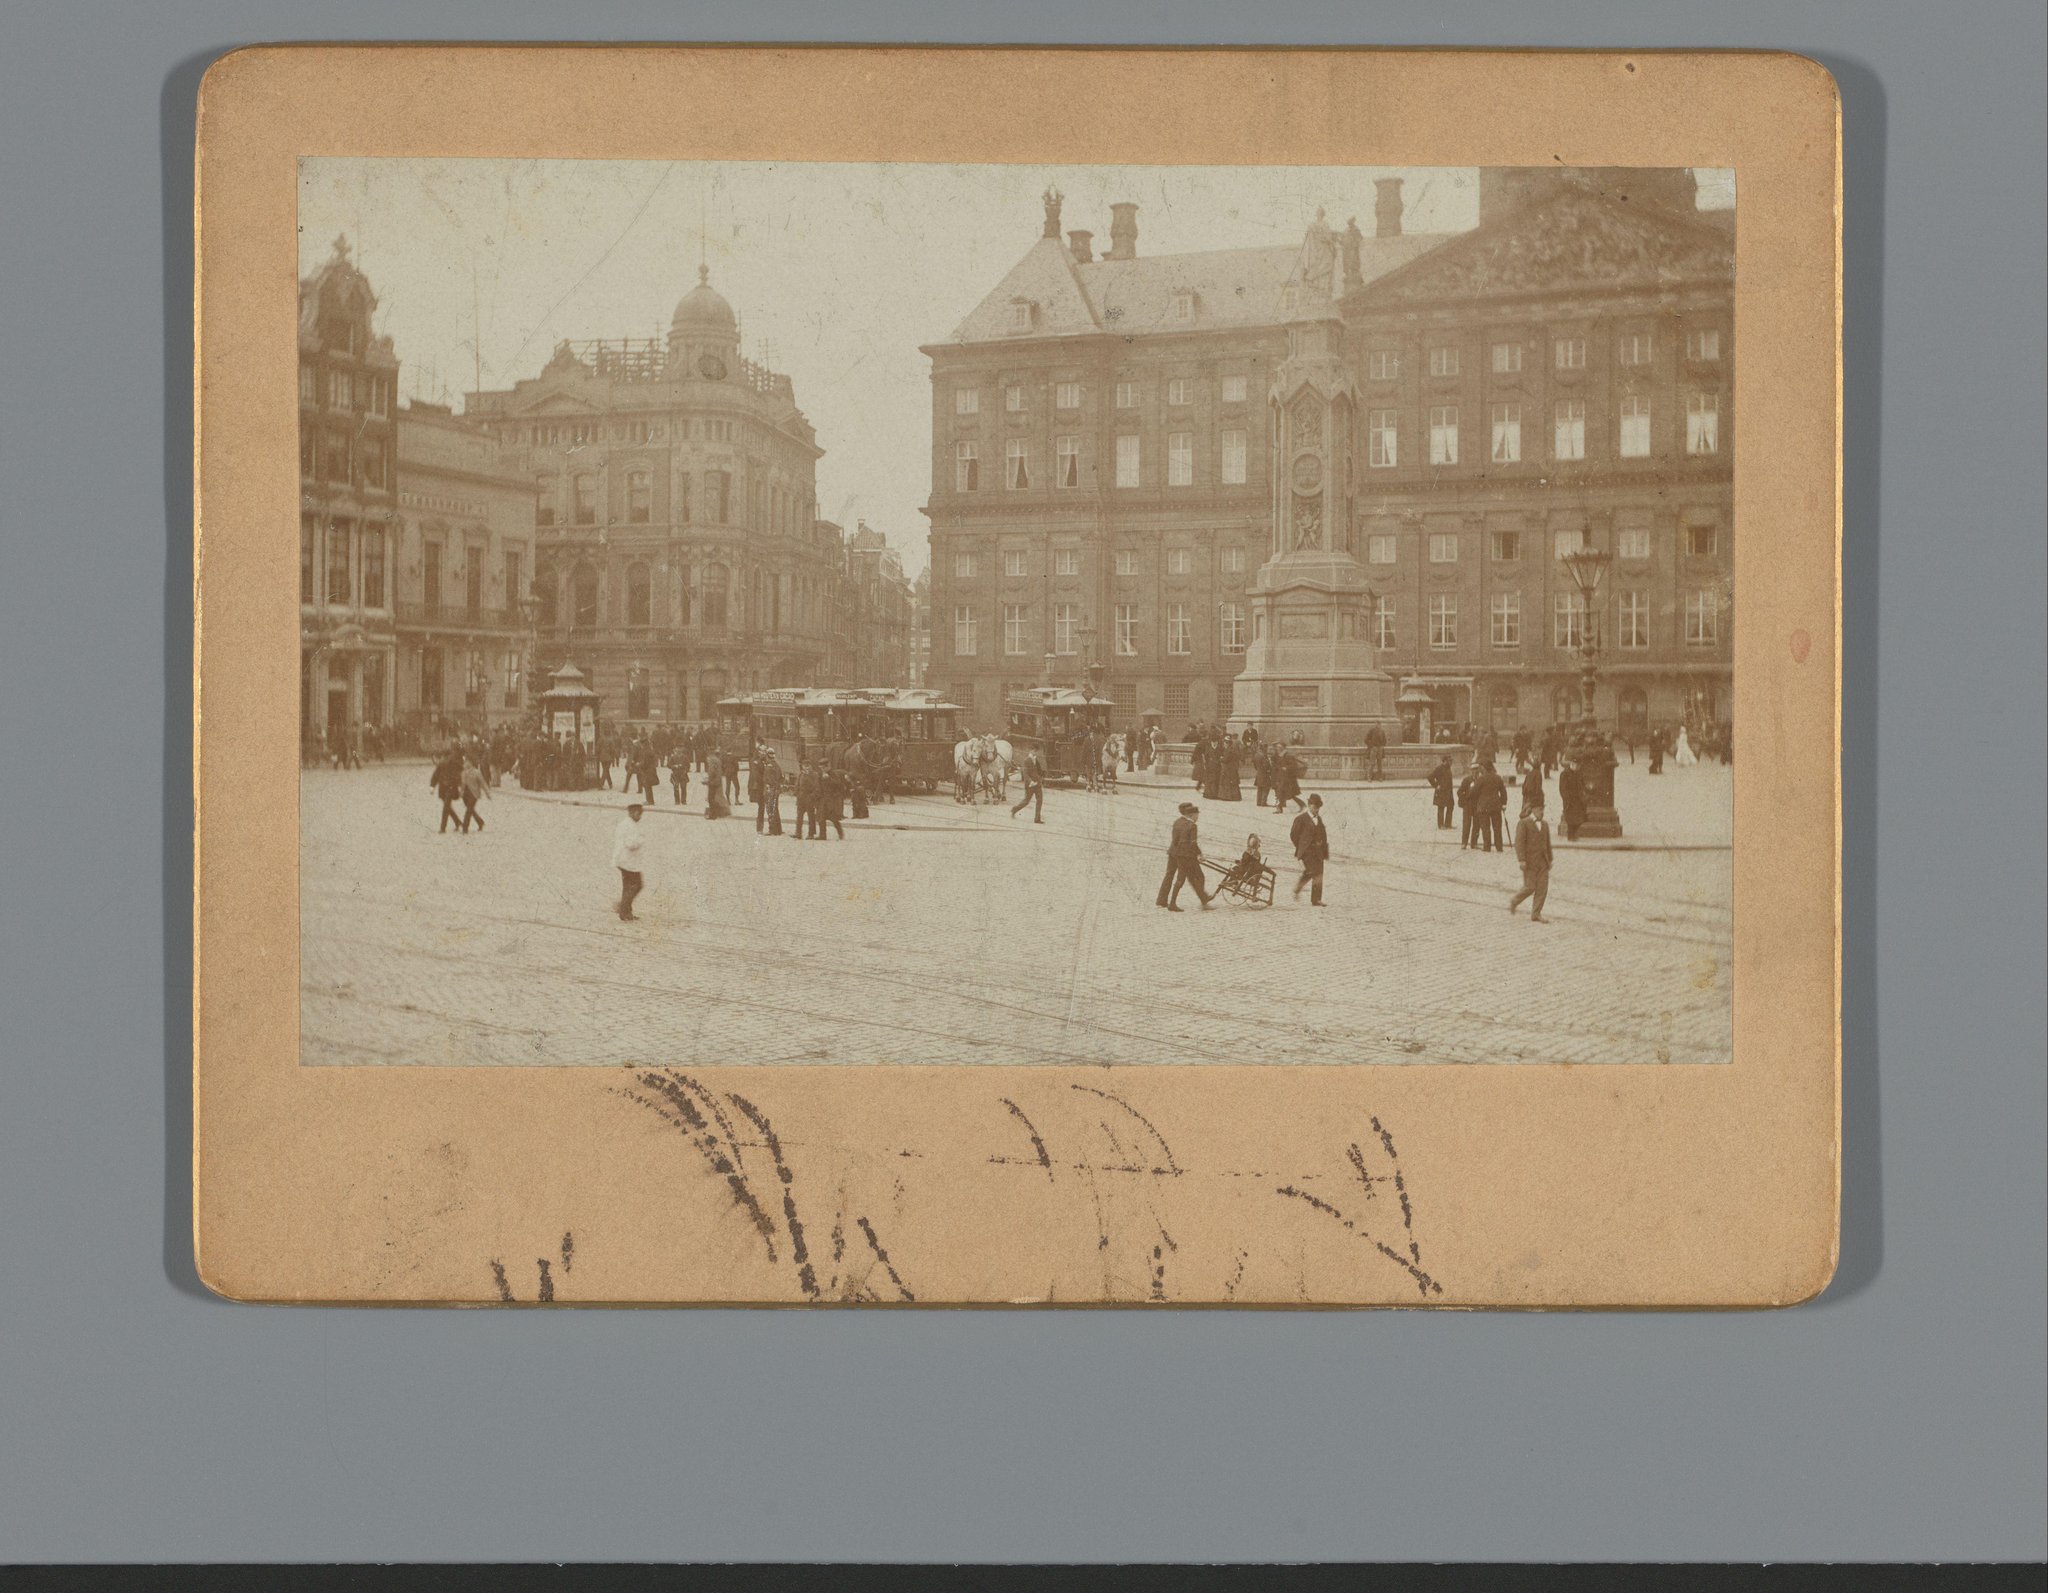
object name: photograph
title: Gezicht op de Dam met paardentrams in Amsterdam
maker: gerrit van der mey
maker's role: gynaecoloog, professor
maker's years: 1851-1895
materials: cardboard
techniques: gelatin silver print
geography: amsterdam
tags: dam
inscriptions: inscription: ‘Mies Schürer Ruth’